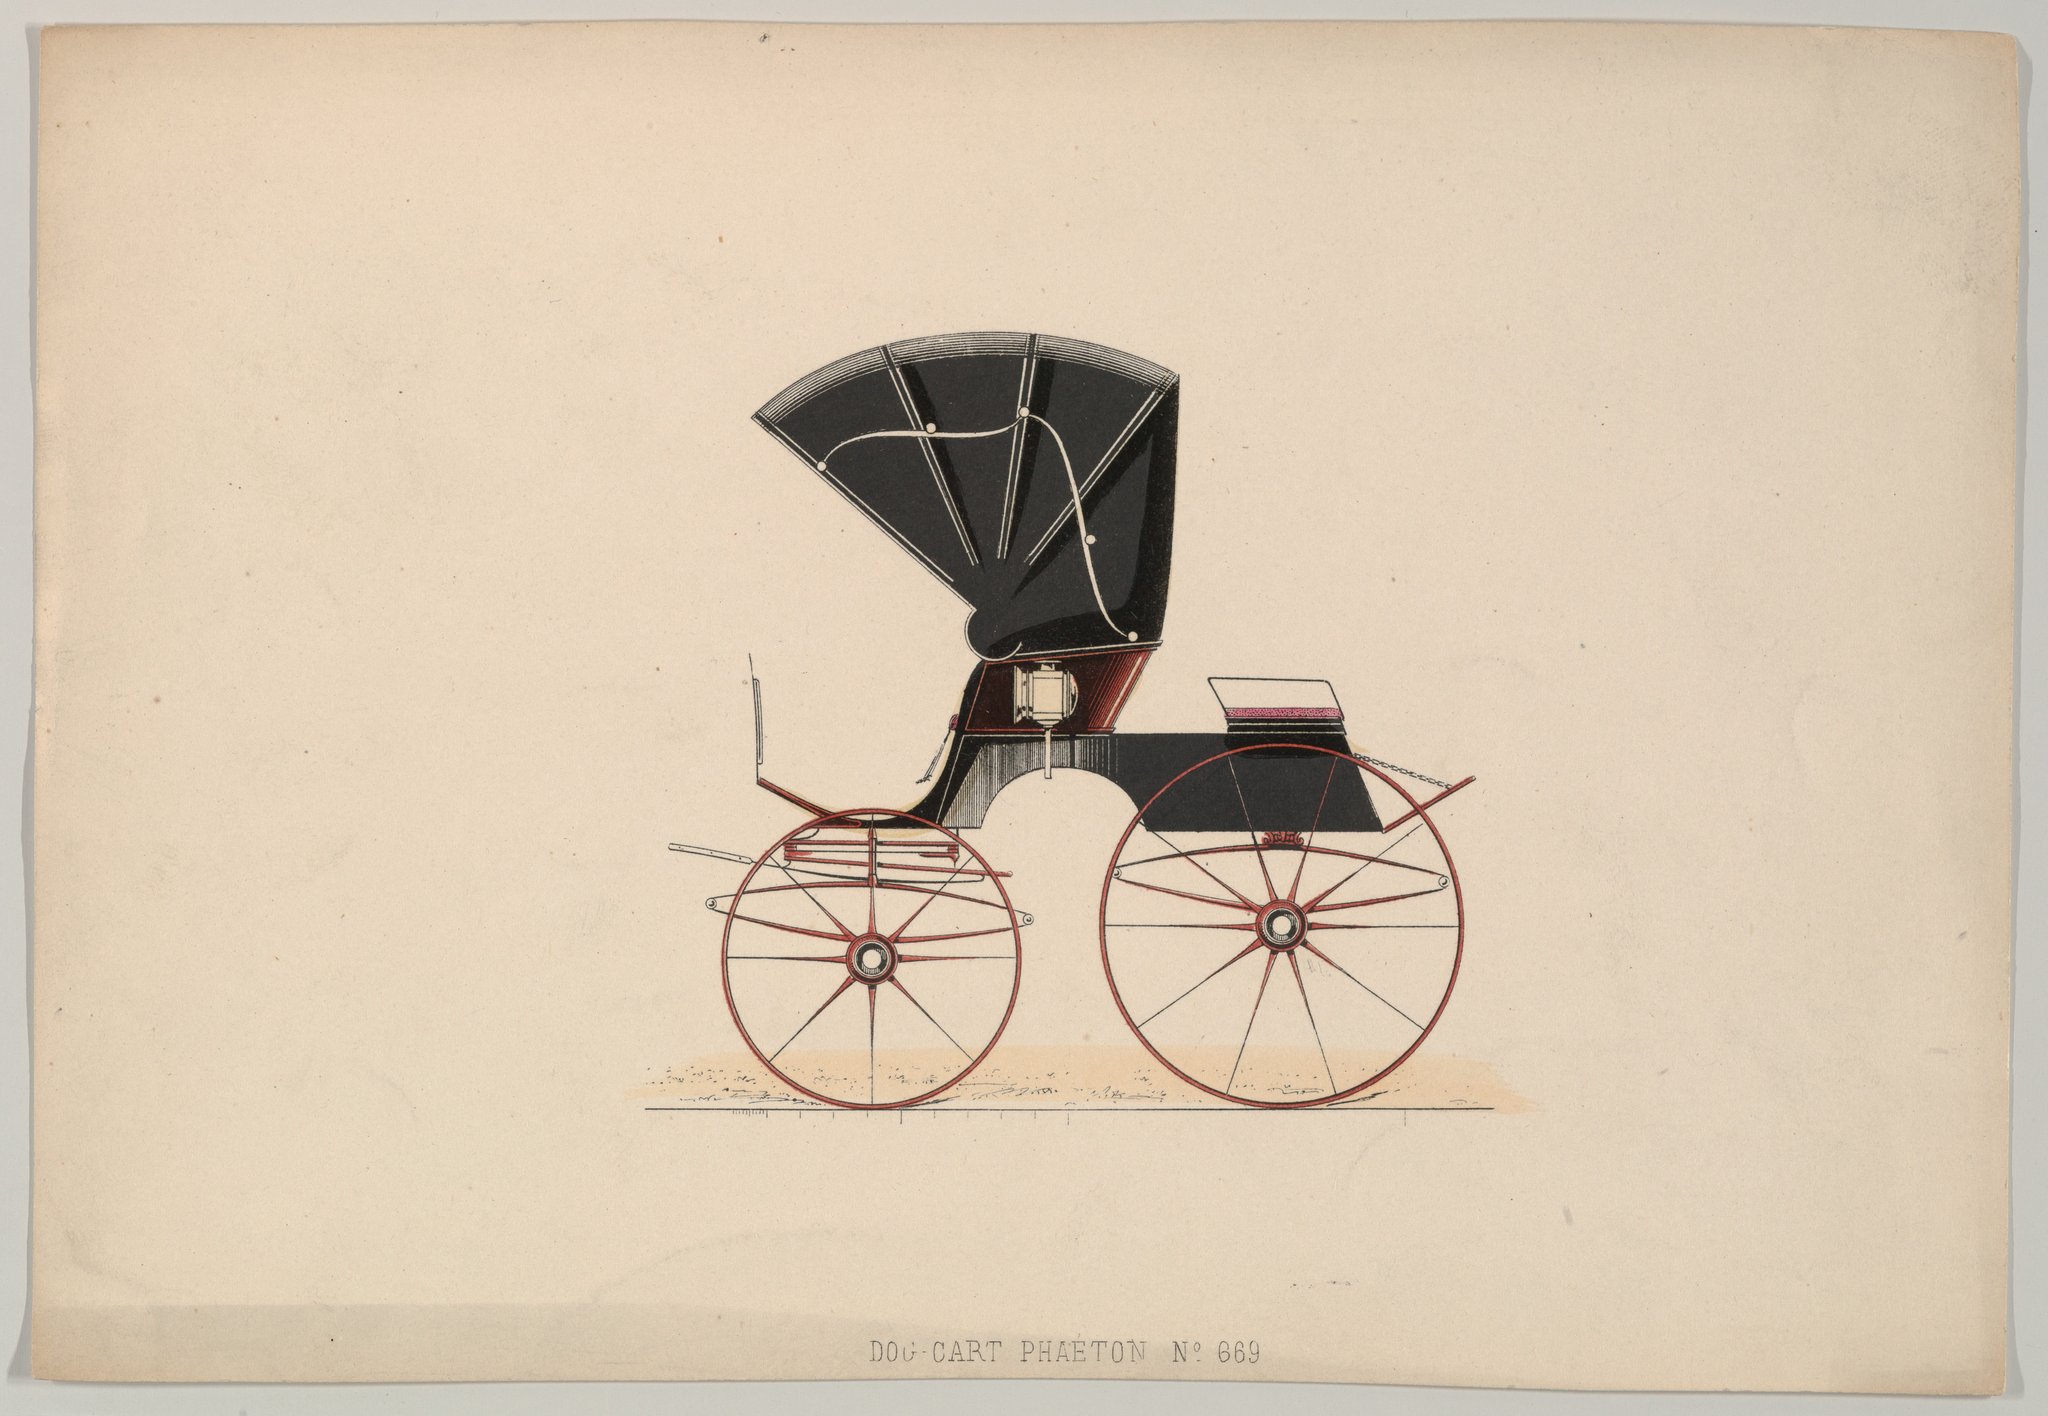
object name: print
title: Design for Dog Cart Phaeton, no. 669, from Le Guide du Carrossier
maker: brice thomas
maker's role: publisher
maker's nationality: french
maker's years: 1830-1890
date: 1870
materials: gum arabic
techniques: hand coloring, lithograph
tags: carriages